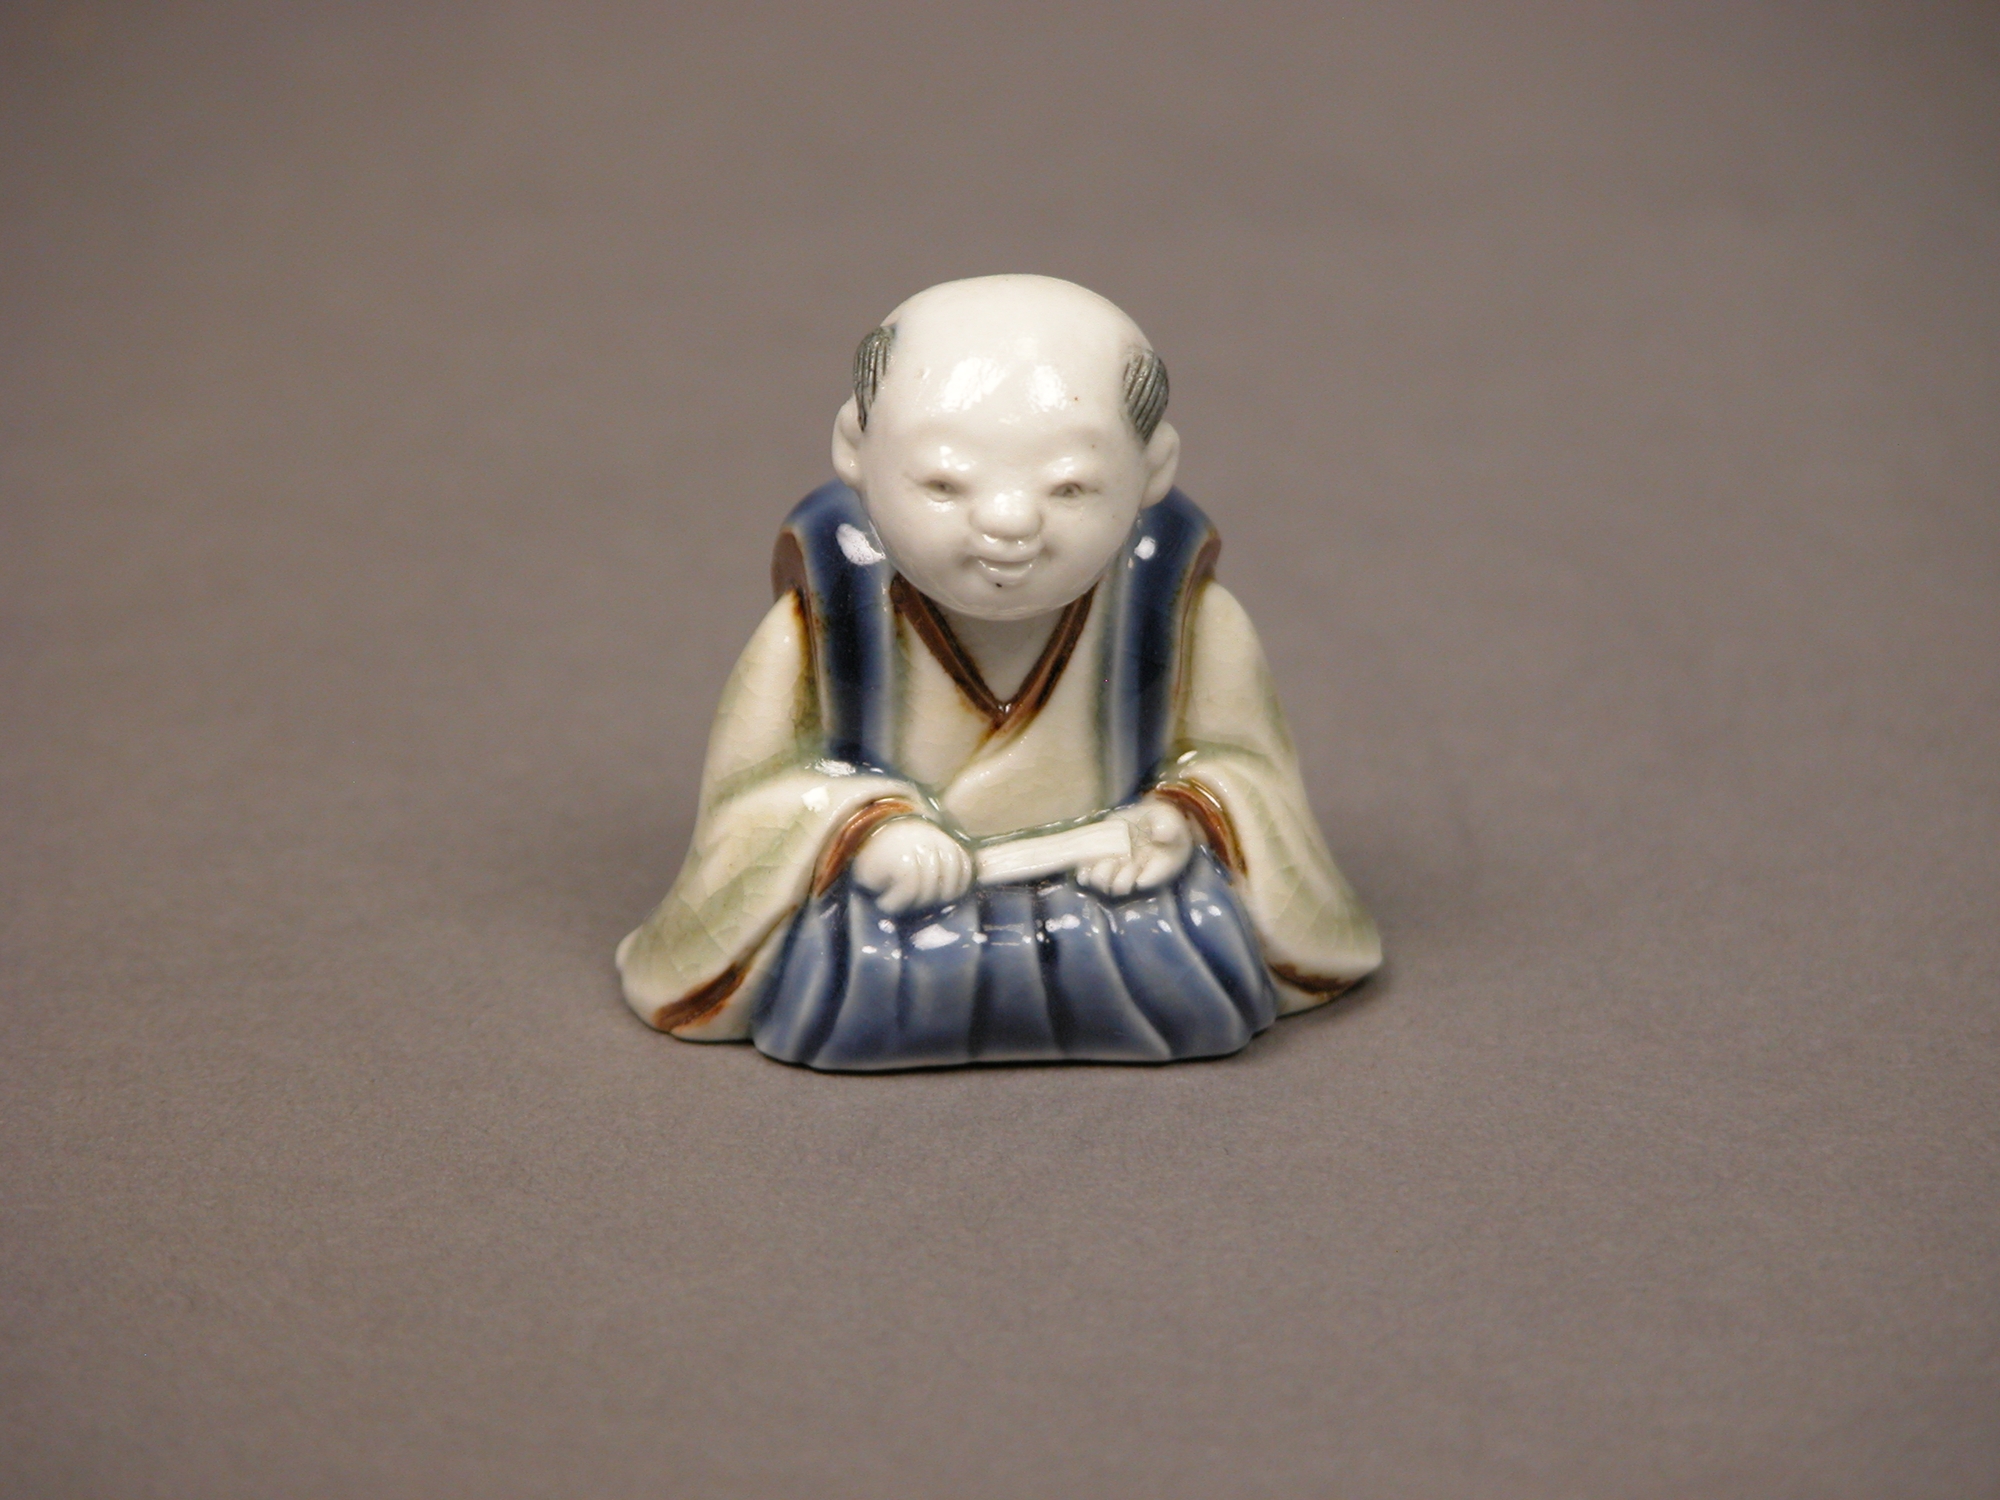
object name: figure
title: Chinese child with musical instrument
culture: japanese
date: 1767-1800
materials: iron, porcelain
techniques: underglaze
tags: musical instruments,children